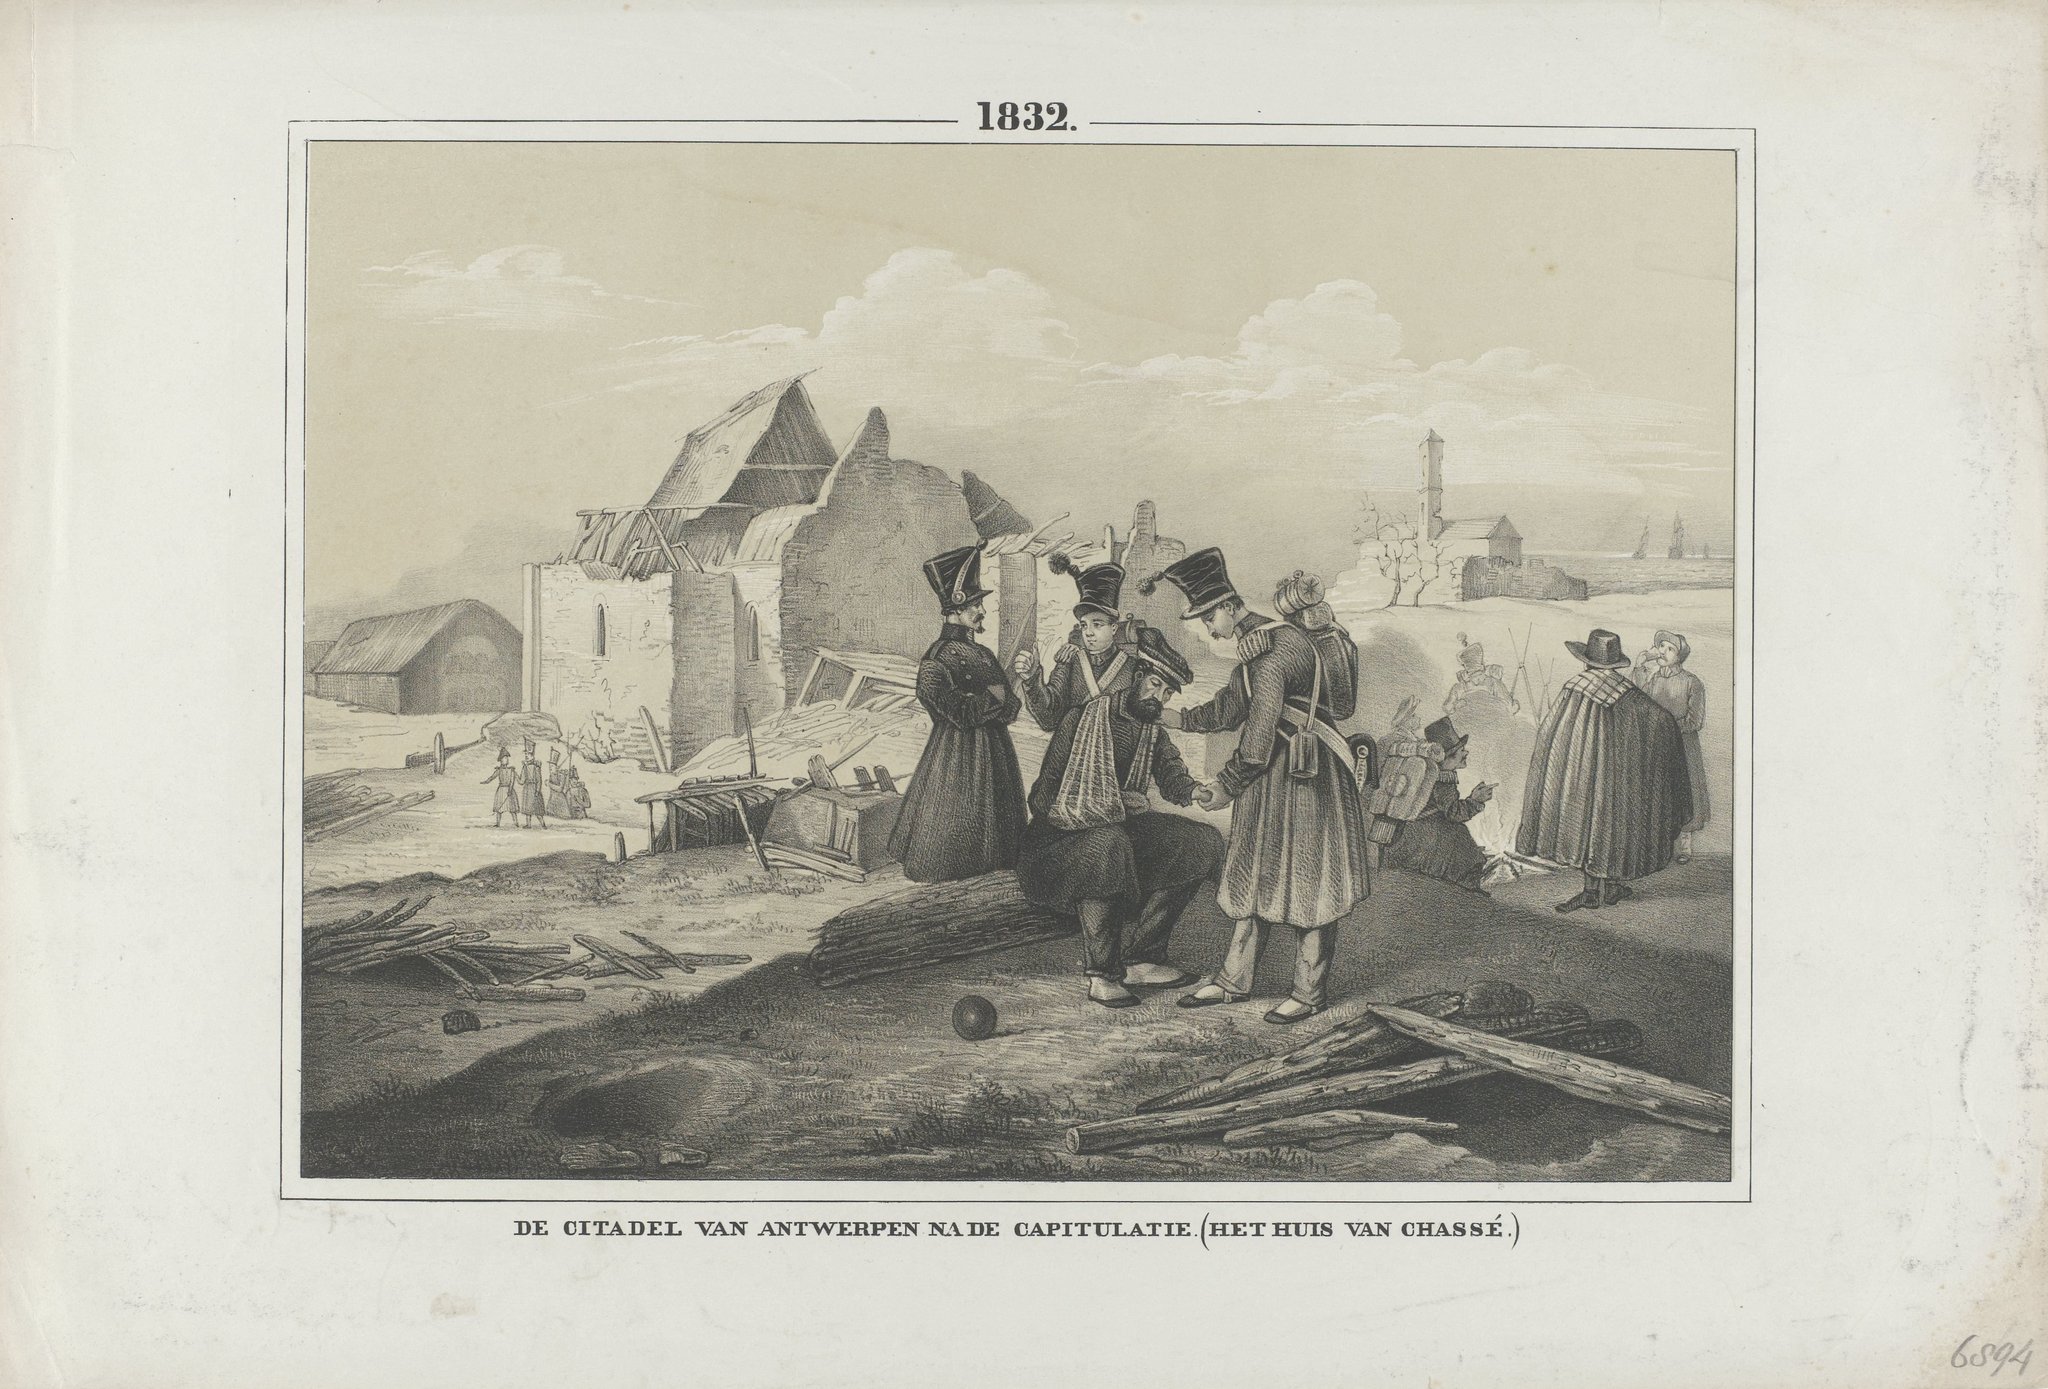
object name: history print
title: Ruïnes van de Citadel van Antwerpen, 1832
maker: Anonymous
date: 1853-1855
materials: paper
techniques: tone lithography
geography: netherlands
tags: permanent fortifications, devastated, ruined place or city (~ warfare)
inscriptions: collector's mark: Lugt 2228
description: Gezicht op de ruïnes van de Citadel van Antwerpen, na het bombardement en de overgave van de citadel door generaal Chassé op 23 december 1832. Centraal een groep van vier militairen waarvan één een gewonde arm heeft.